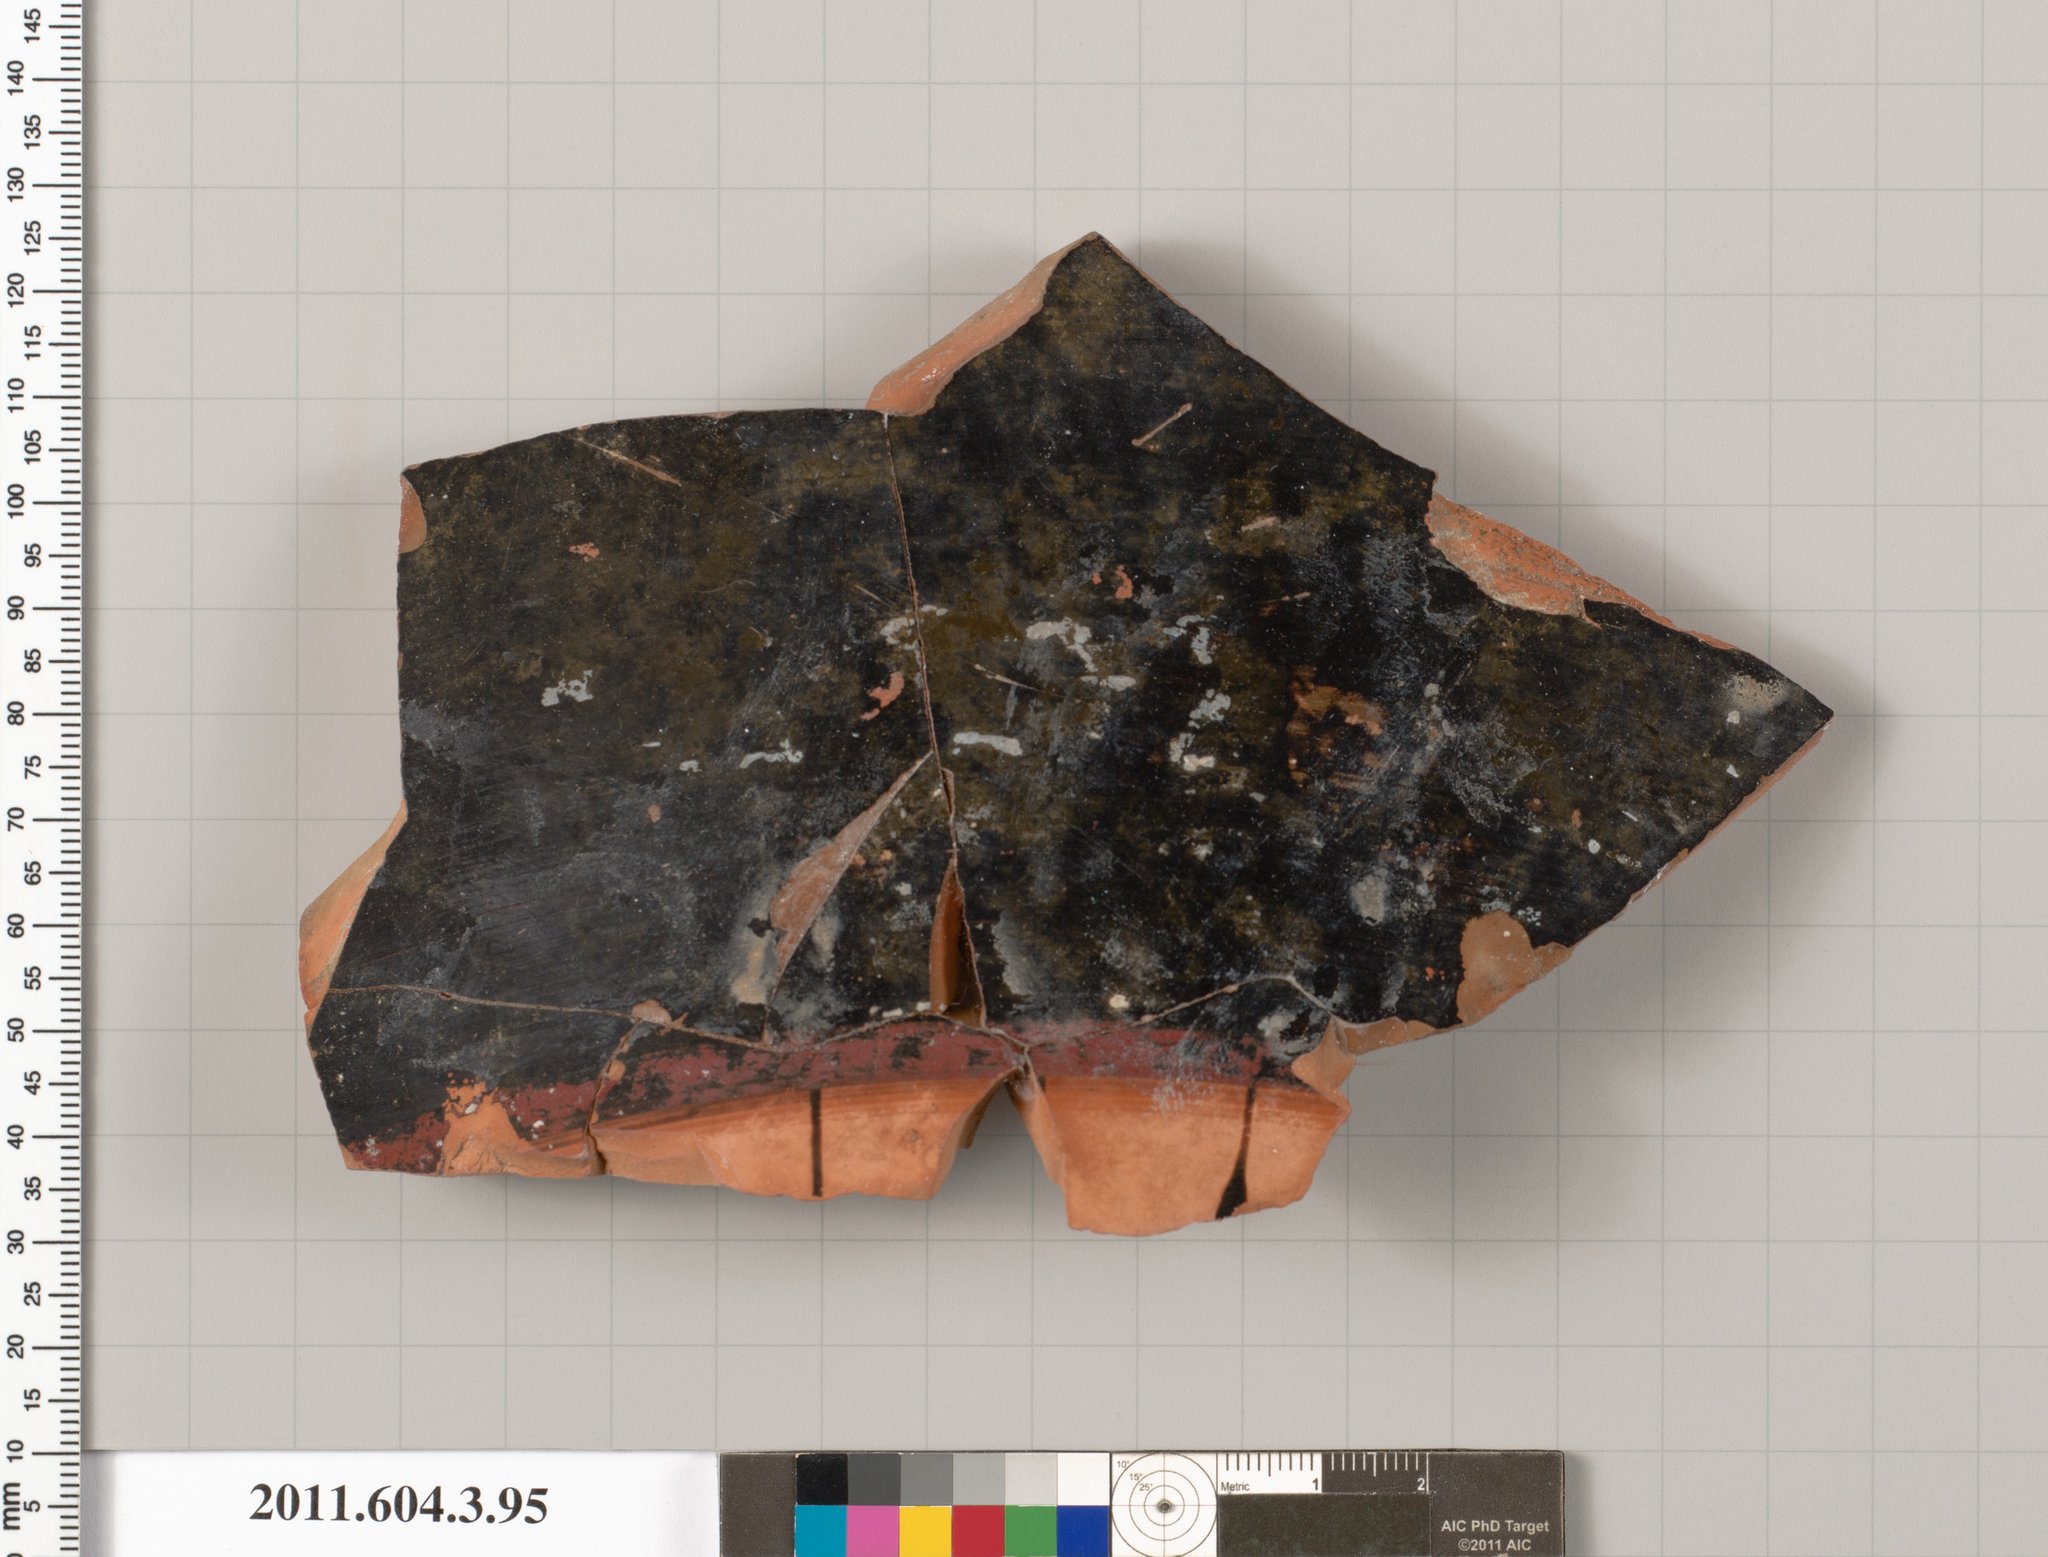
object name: amphora fragment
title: Terracotta fragment of an amphora (jar)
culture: greek, attic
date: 600-468 BCE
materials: terracotta